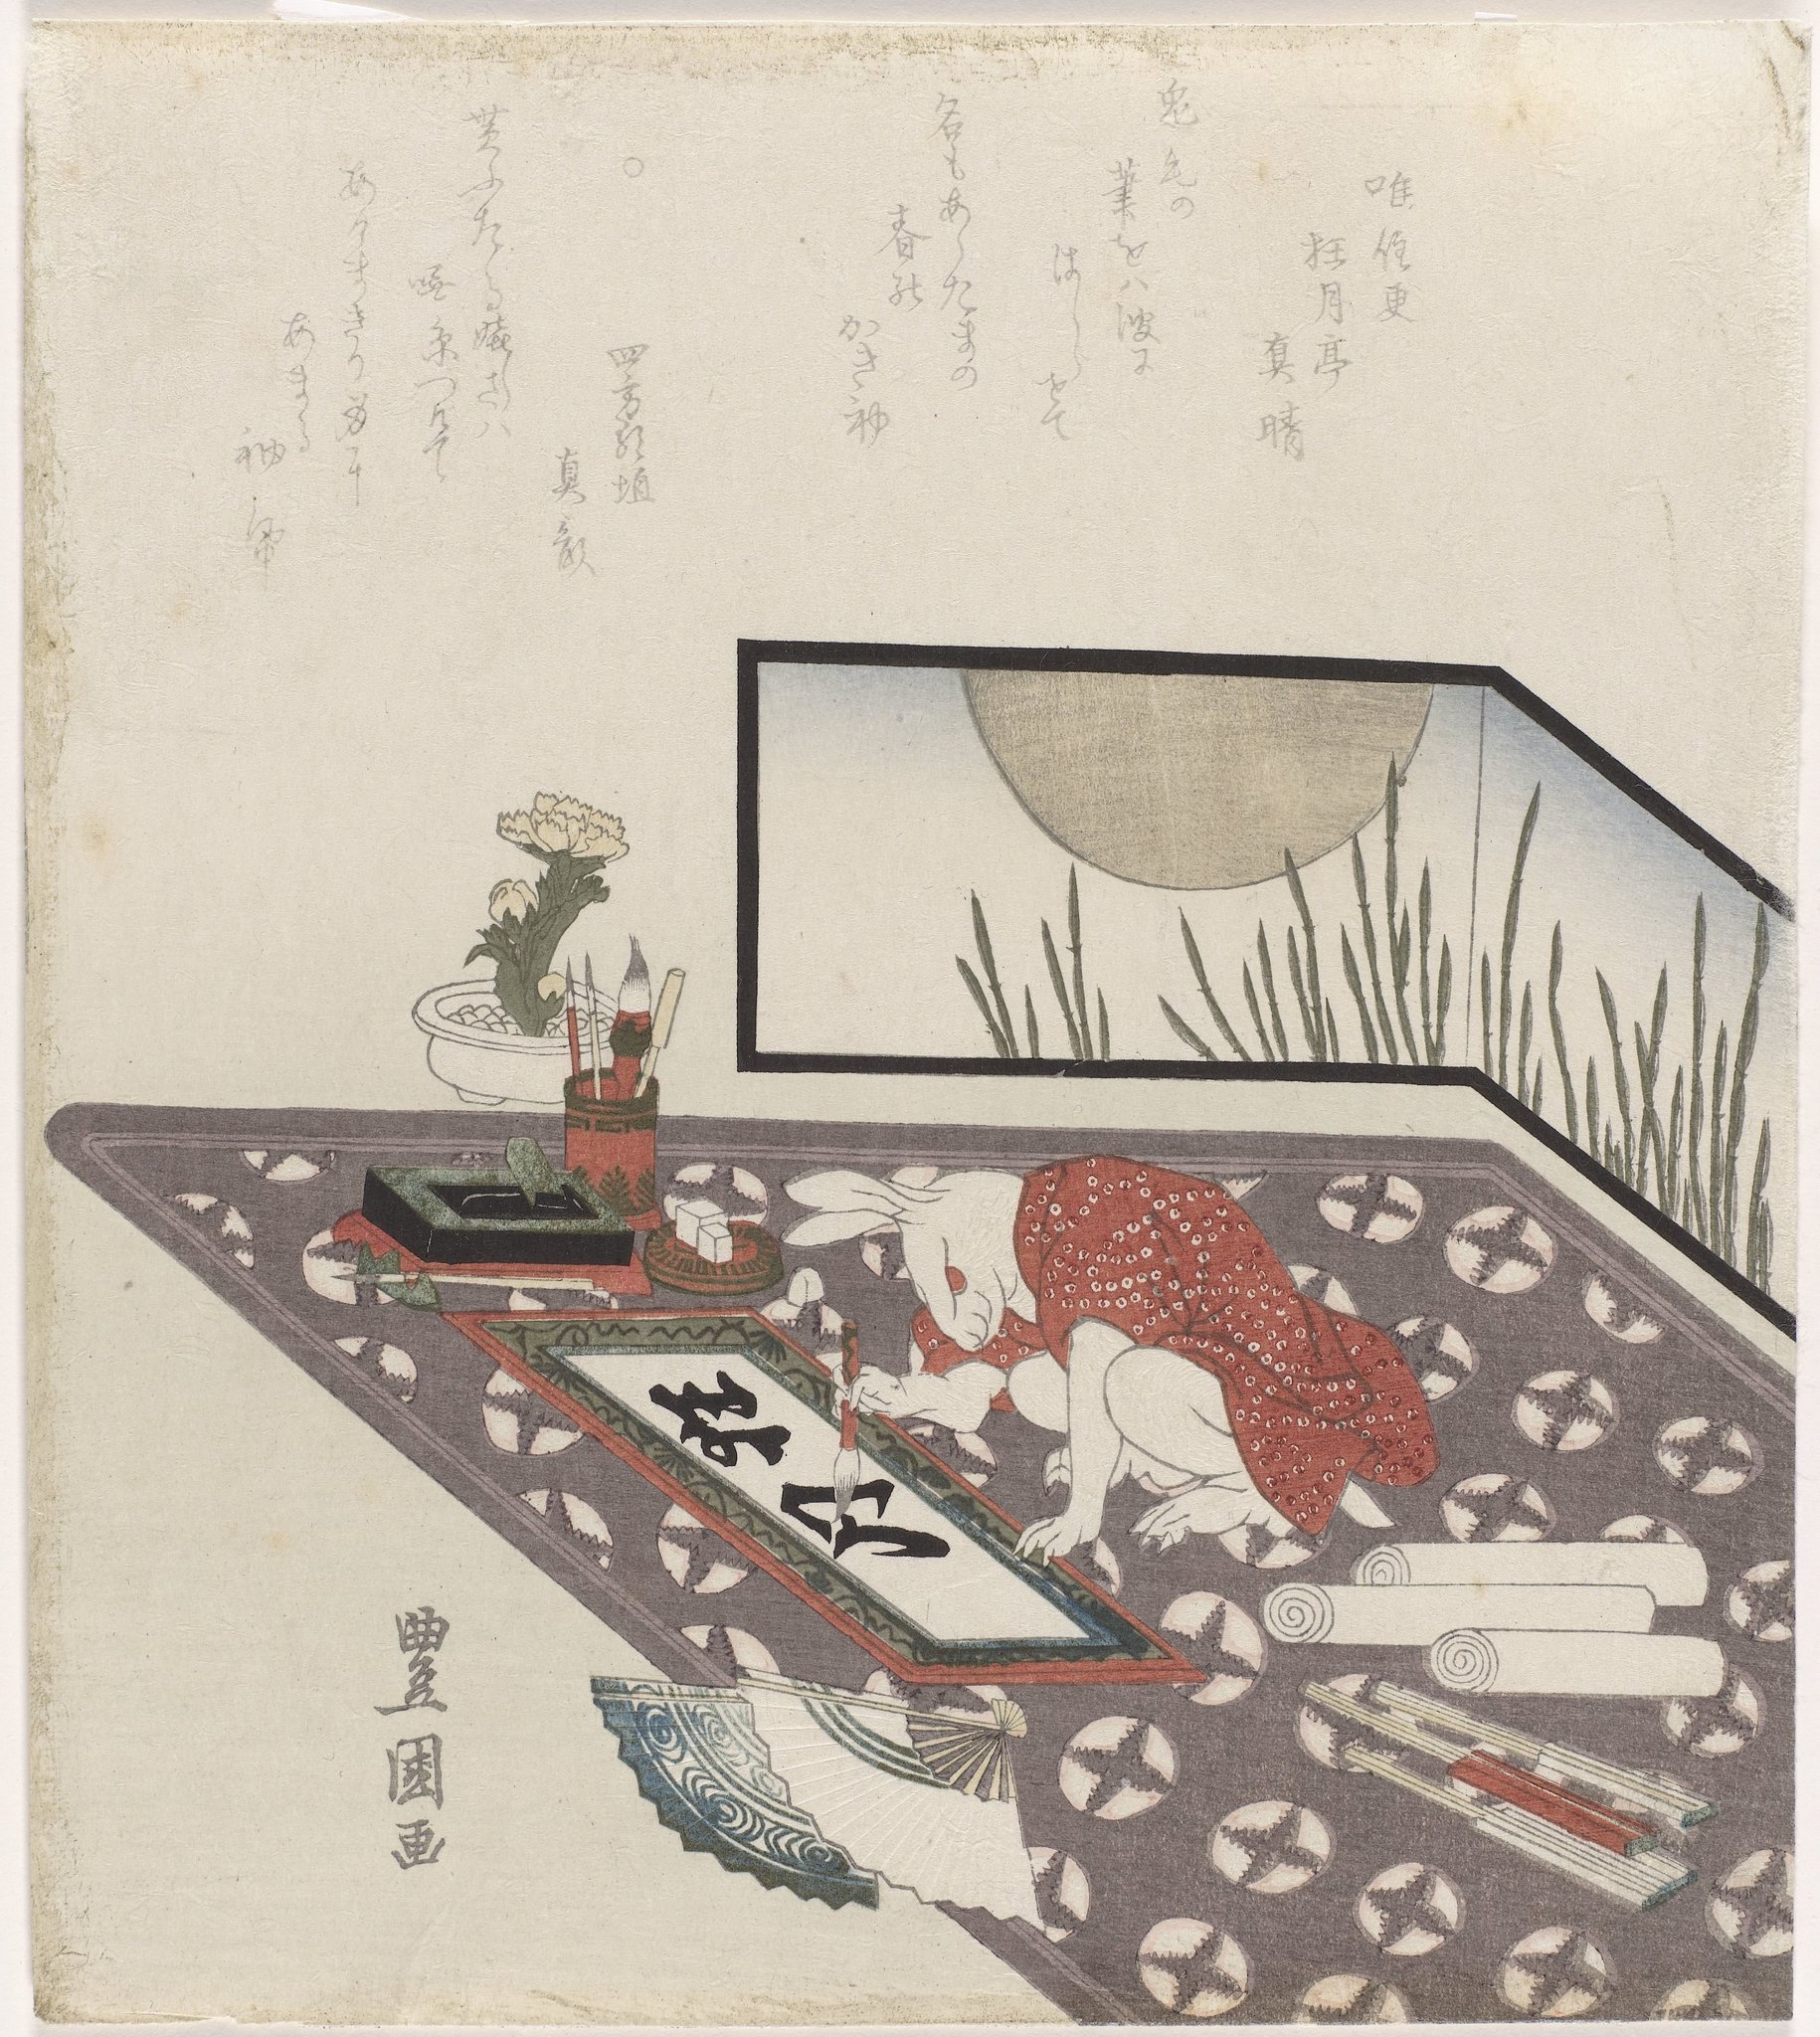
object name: print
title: Haas die een nieuwjaarswens voor het jaar van de Haas (1819) calligrafeert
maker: utagawa toyokuni (i)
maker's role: print maker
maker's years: 1769-1825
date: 1819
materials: paper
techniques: woodcut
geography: japan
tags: rodents: hare, calligraphy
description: Een surimono is een luxe uitgevoerde prent waarop beeld met één of meerdere gedichten gecombineerd is. Bij het drukken van een surimono werd vaak gebruik gemaakt van dikker papier, blinddruk en metaal pigmenten, zoals koper- en zilverpoeder. De prenten werden vaak in opdracht van dichters gemaakt en als exclusief geschenk aan vrienden en relaties gegeven.